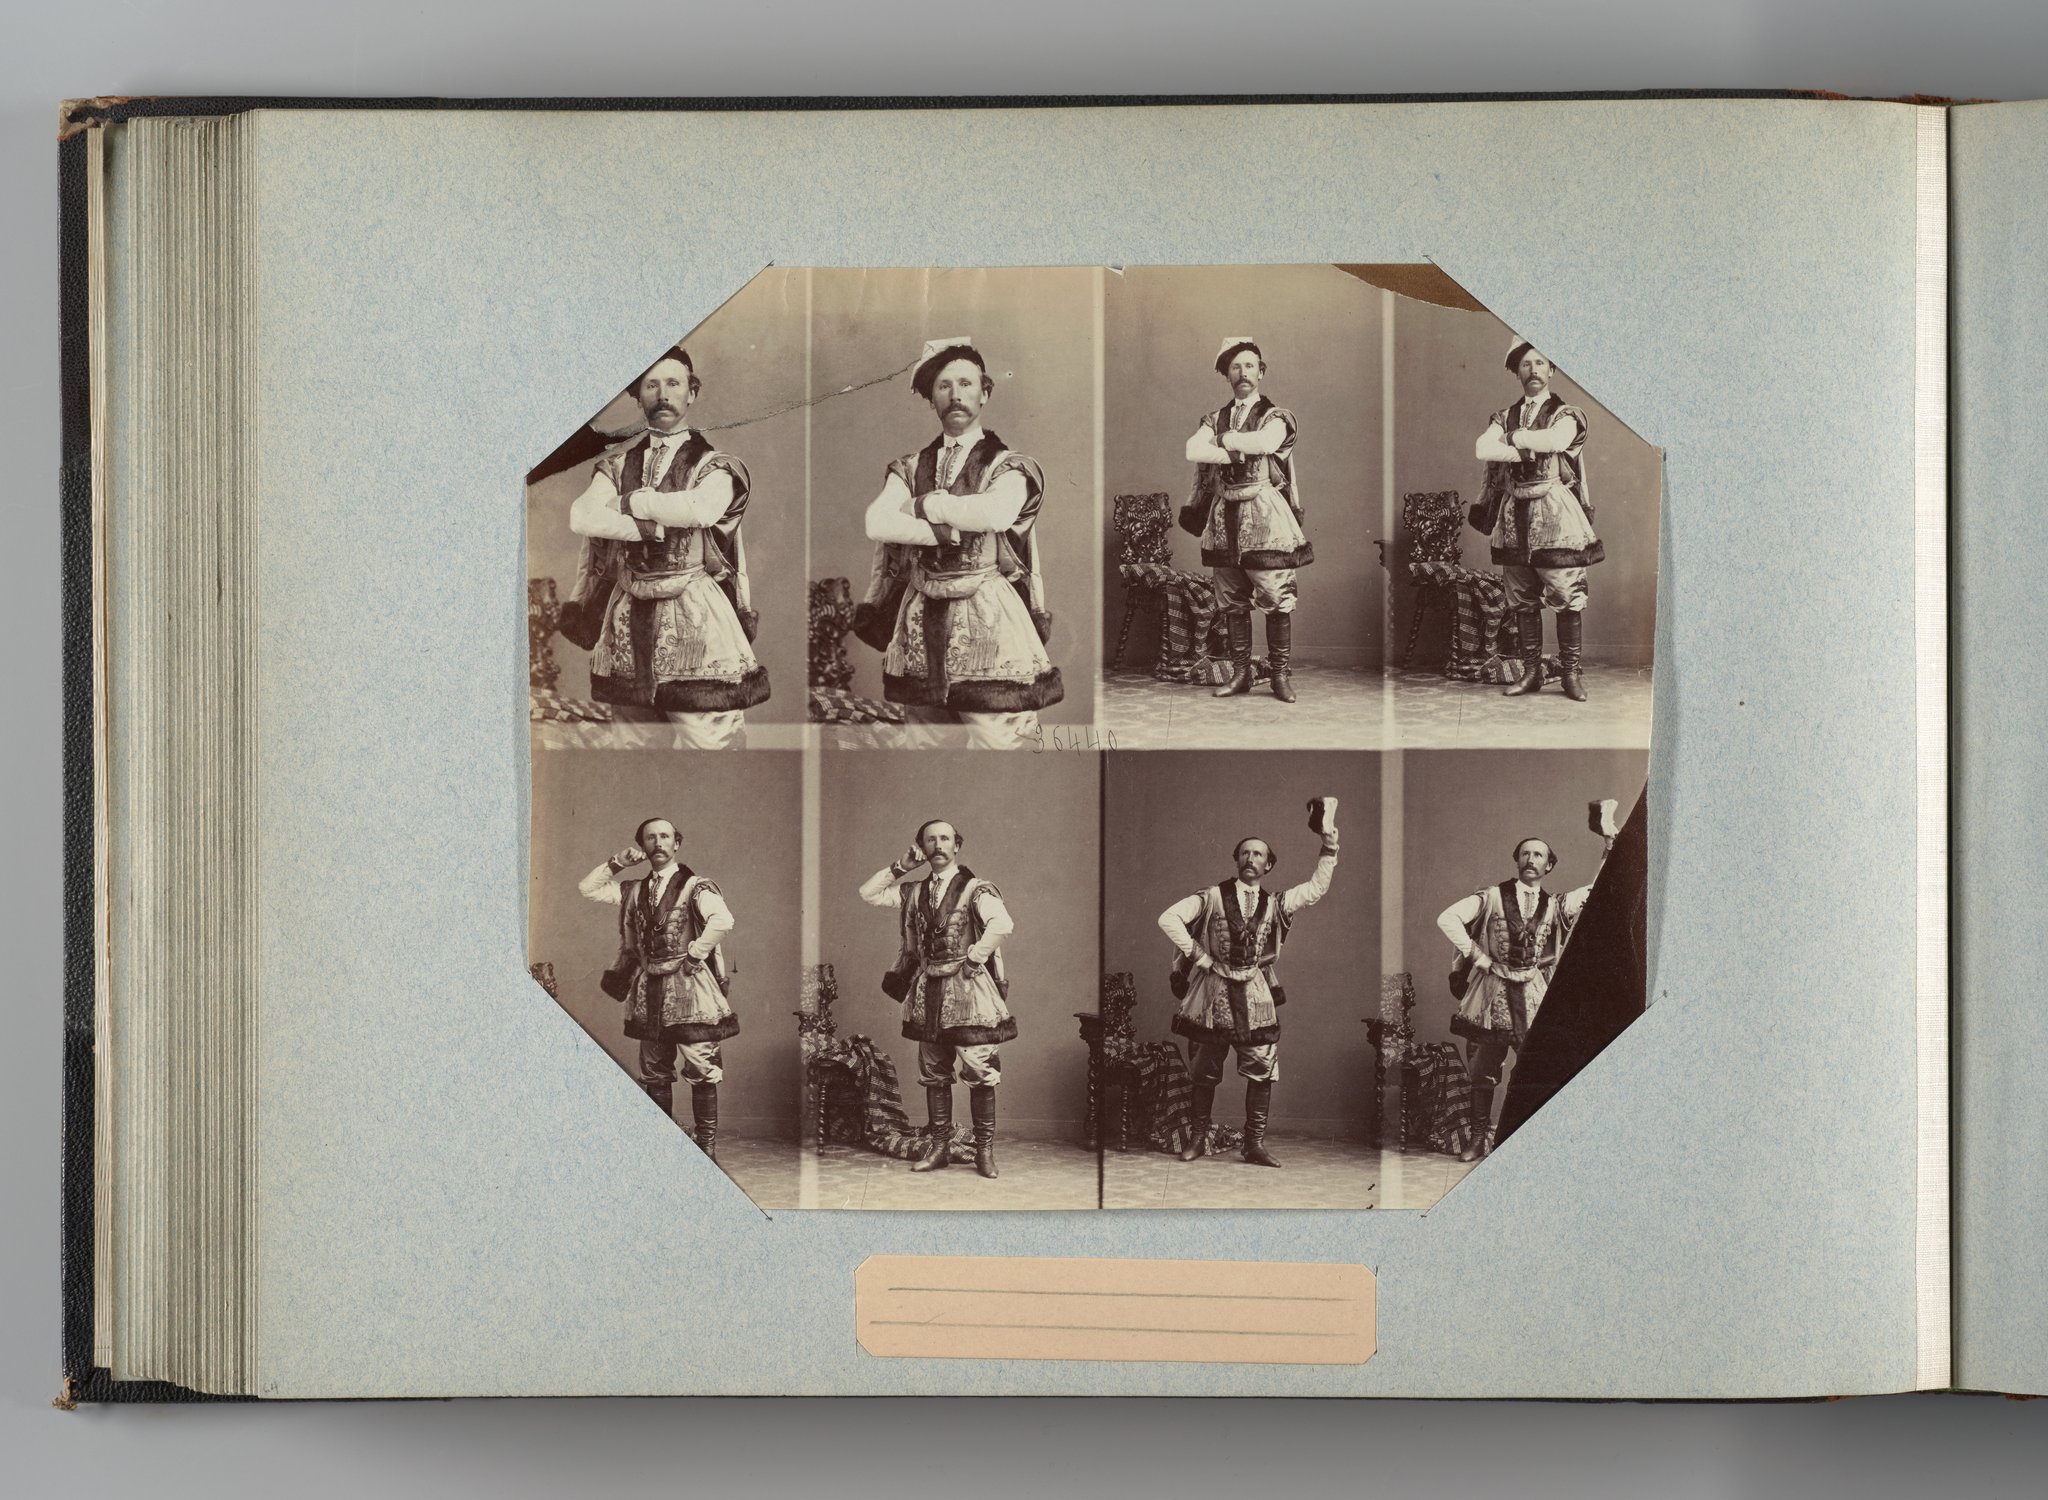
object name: photograph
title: Mechesinski [?]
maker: andré-adolphe-eugène disdéri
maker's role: artist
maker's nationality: french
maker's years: 1819-1889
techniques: albumen silver print, glass negative